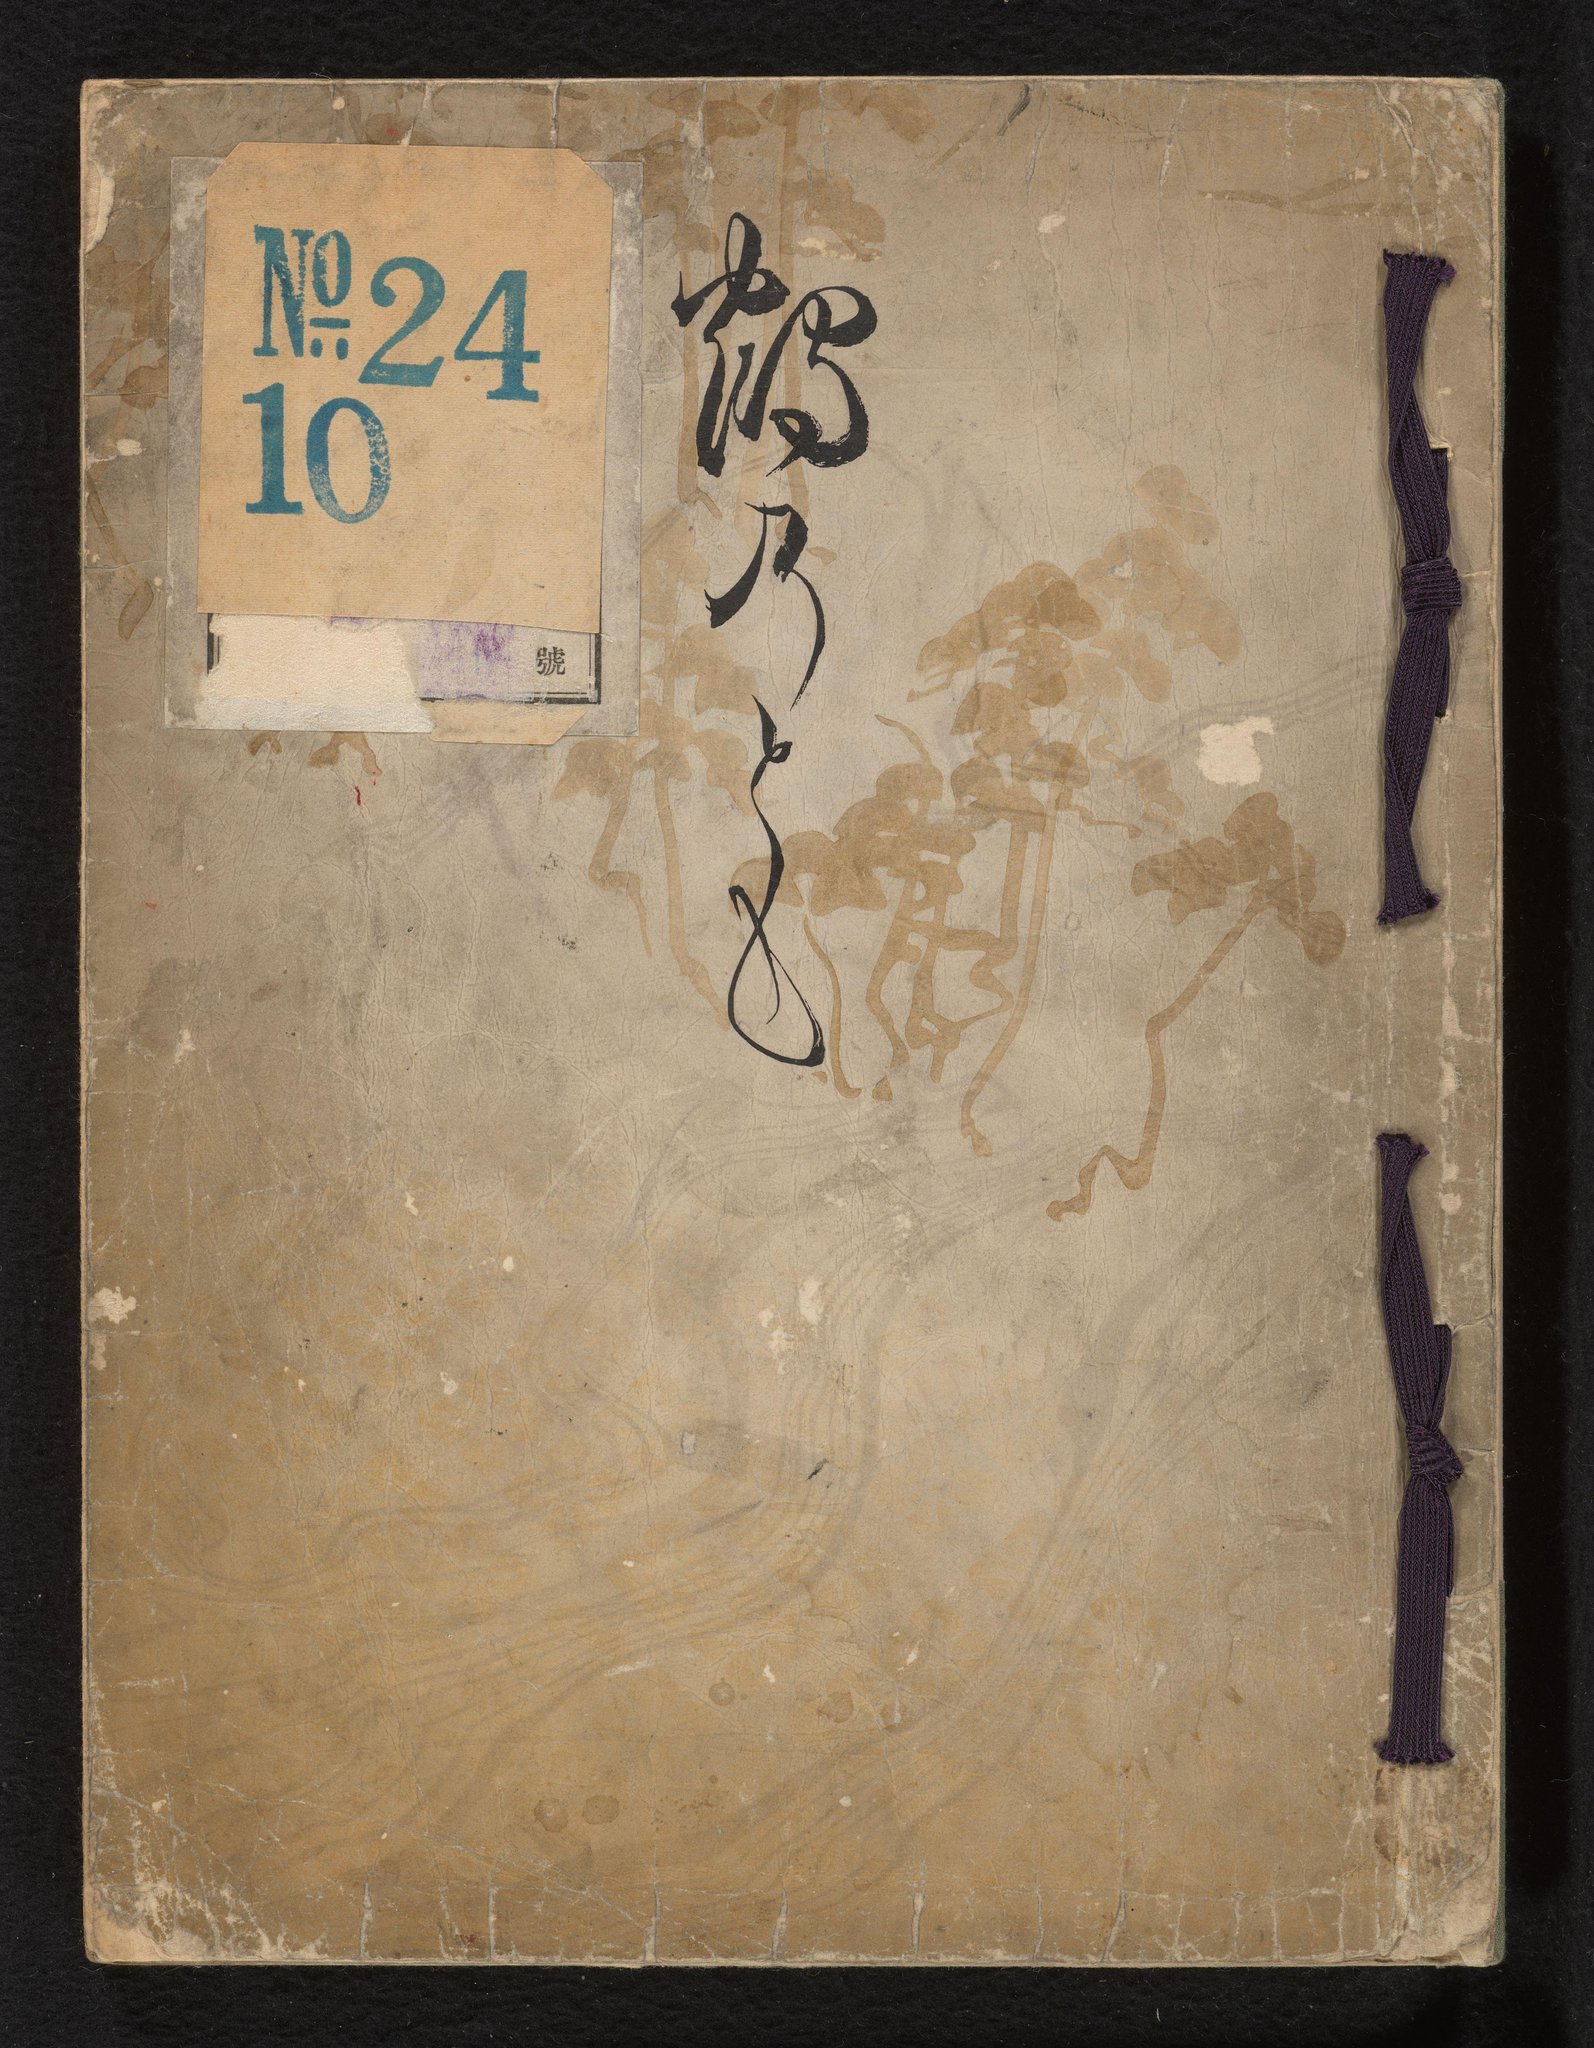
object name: book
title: Poem Collection for the 77th Birthday of Ôkura Tsuruhiko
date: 1916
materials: paper